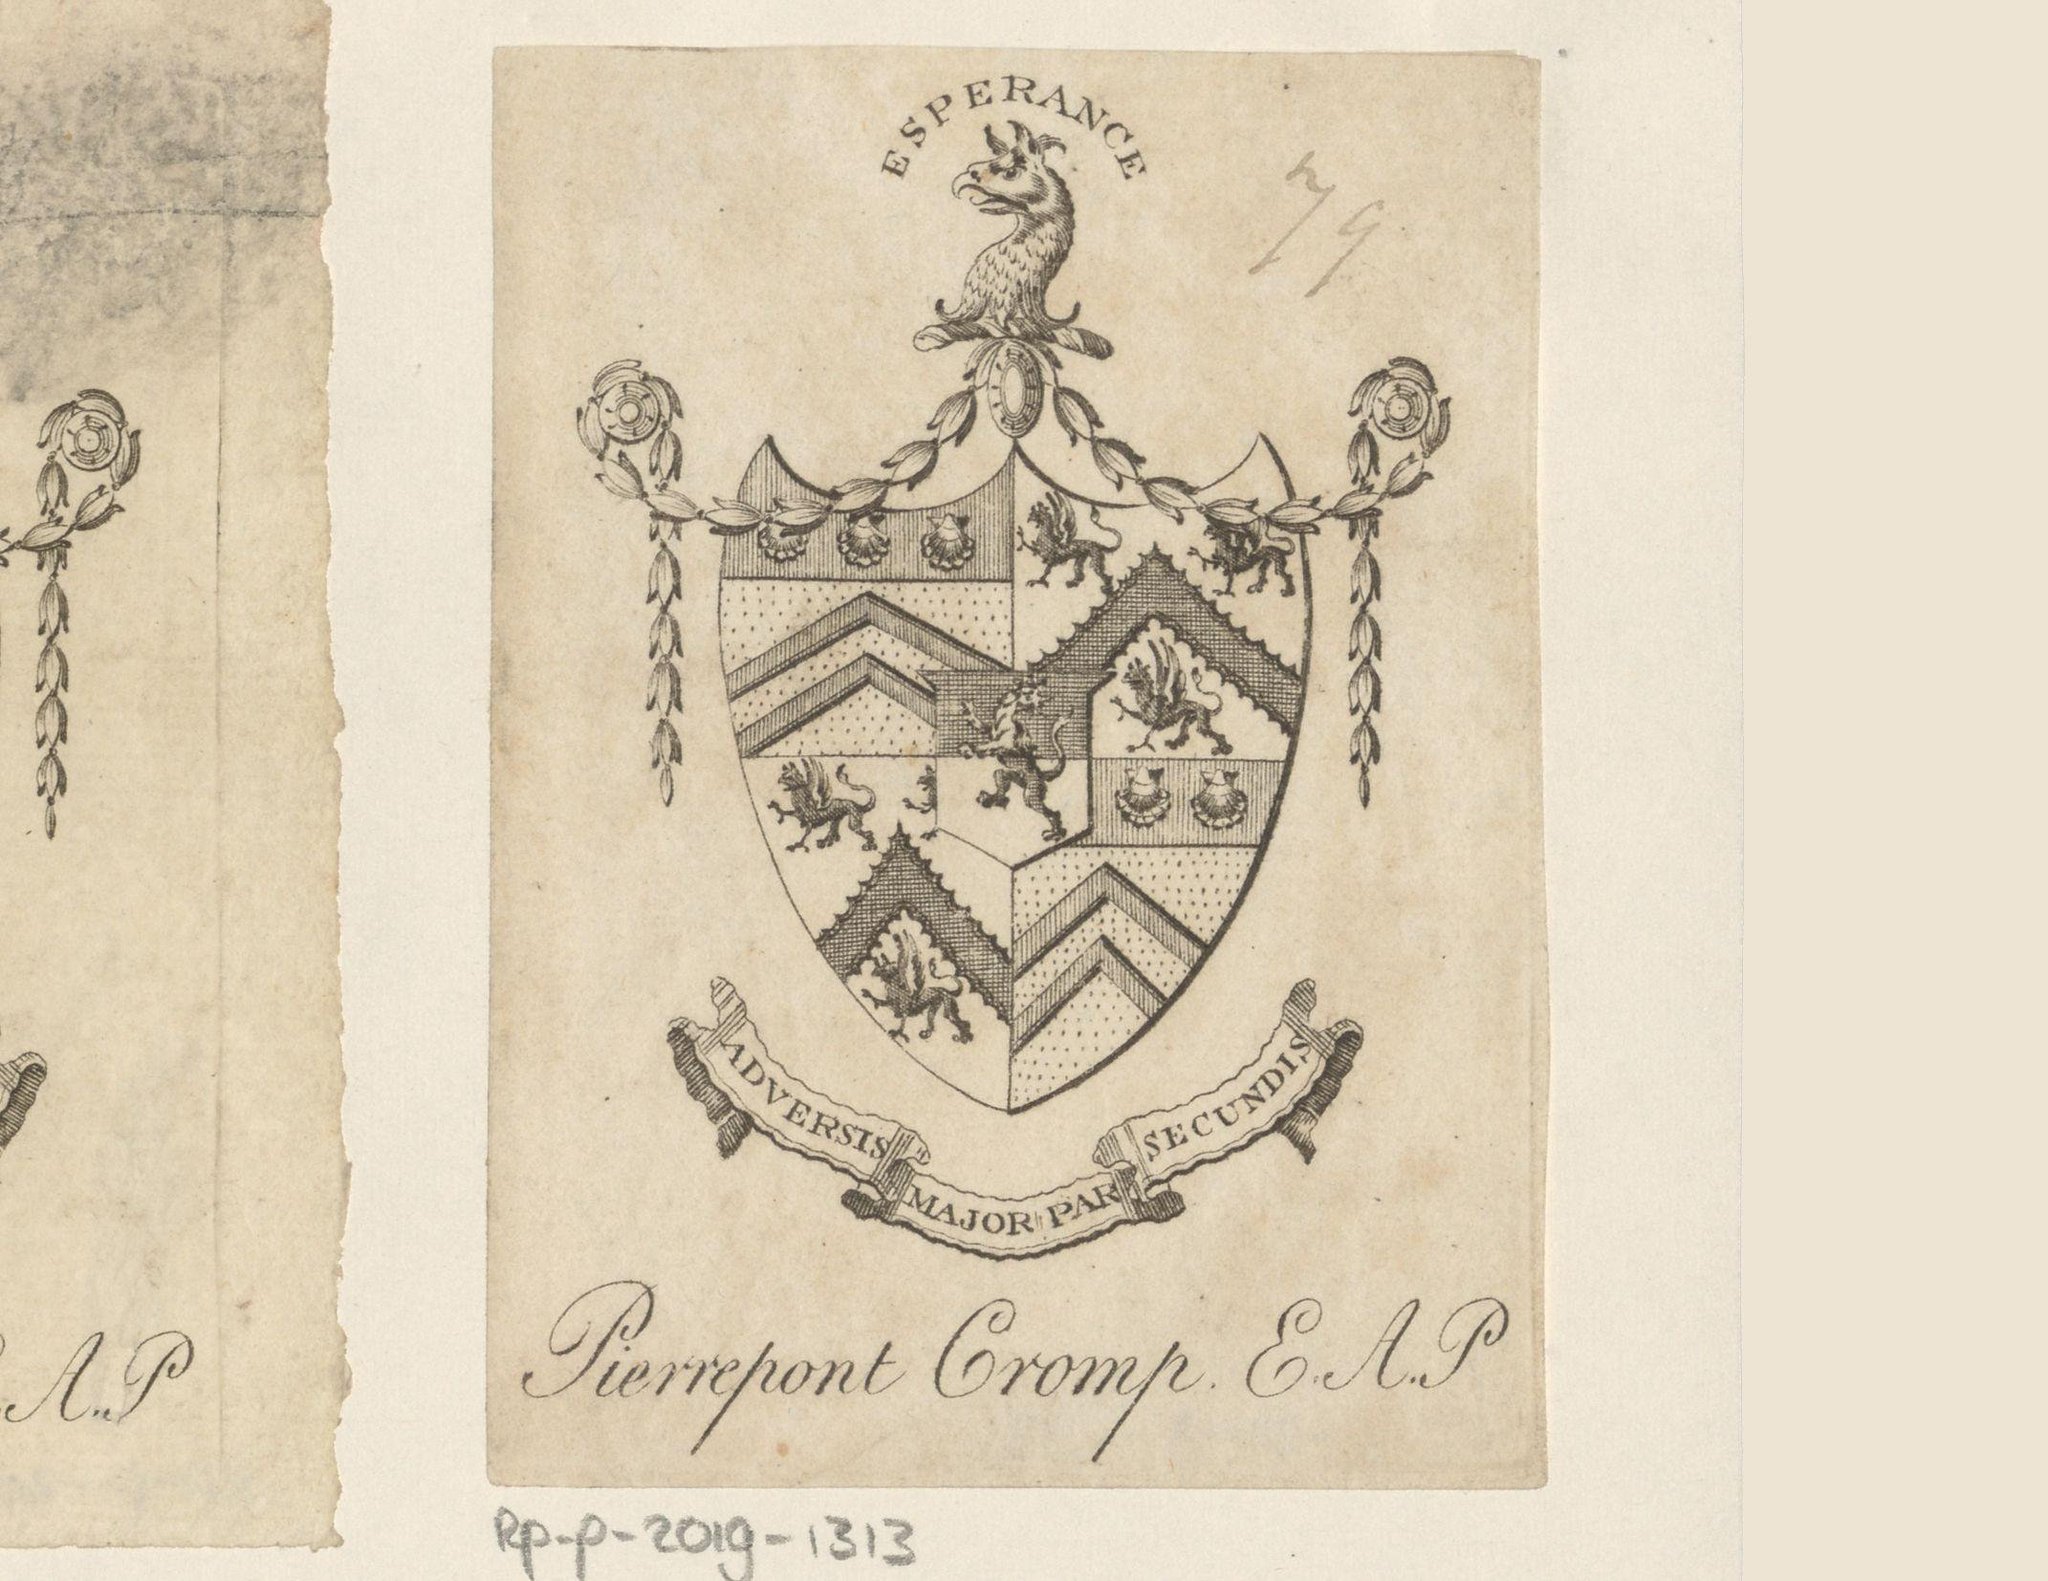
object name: bookplate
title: Ex libris van Pierrepont Cromp. E.A.P.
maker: Anonymous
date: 1700-1799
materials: paper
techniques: engraving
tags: armorial bearing, heraldry